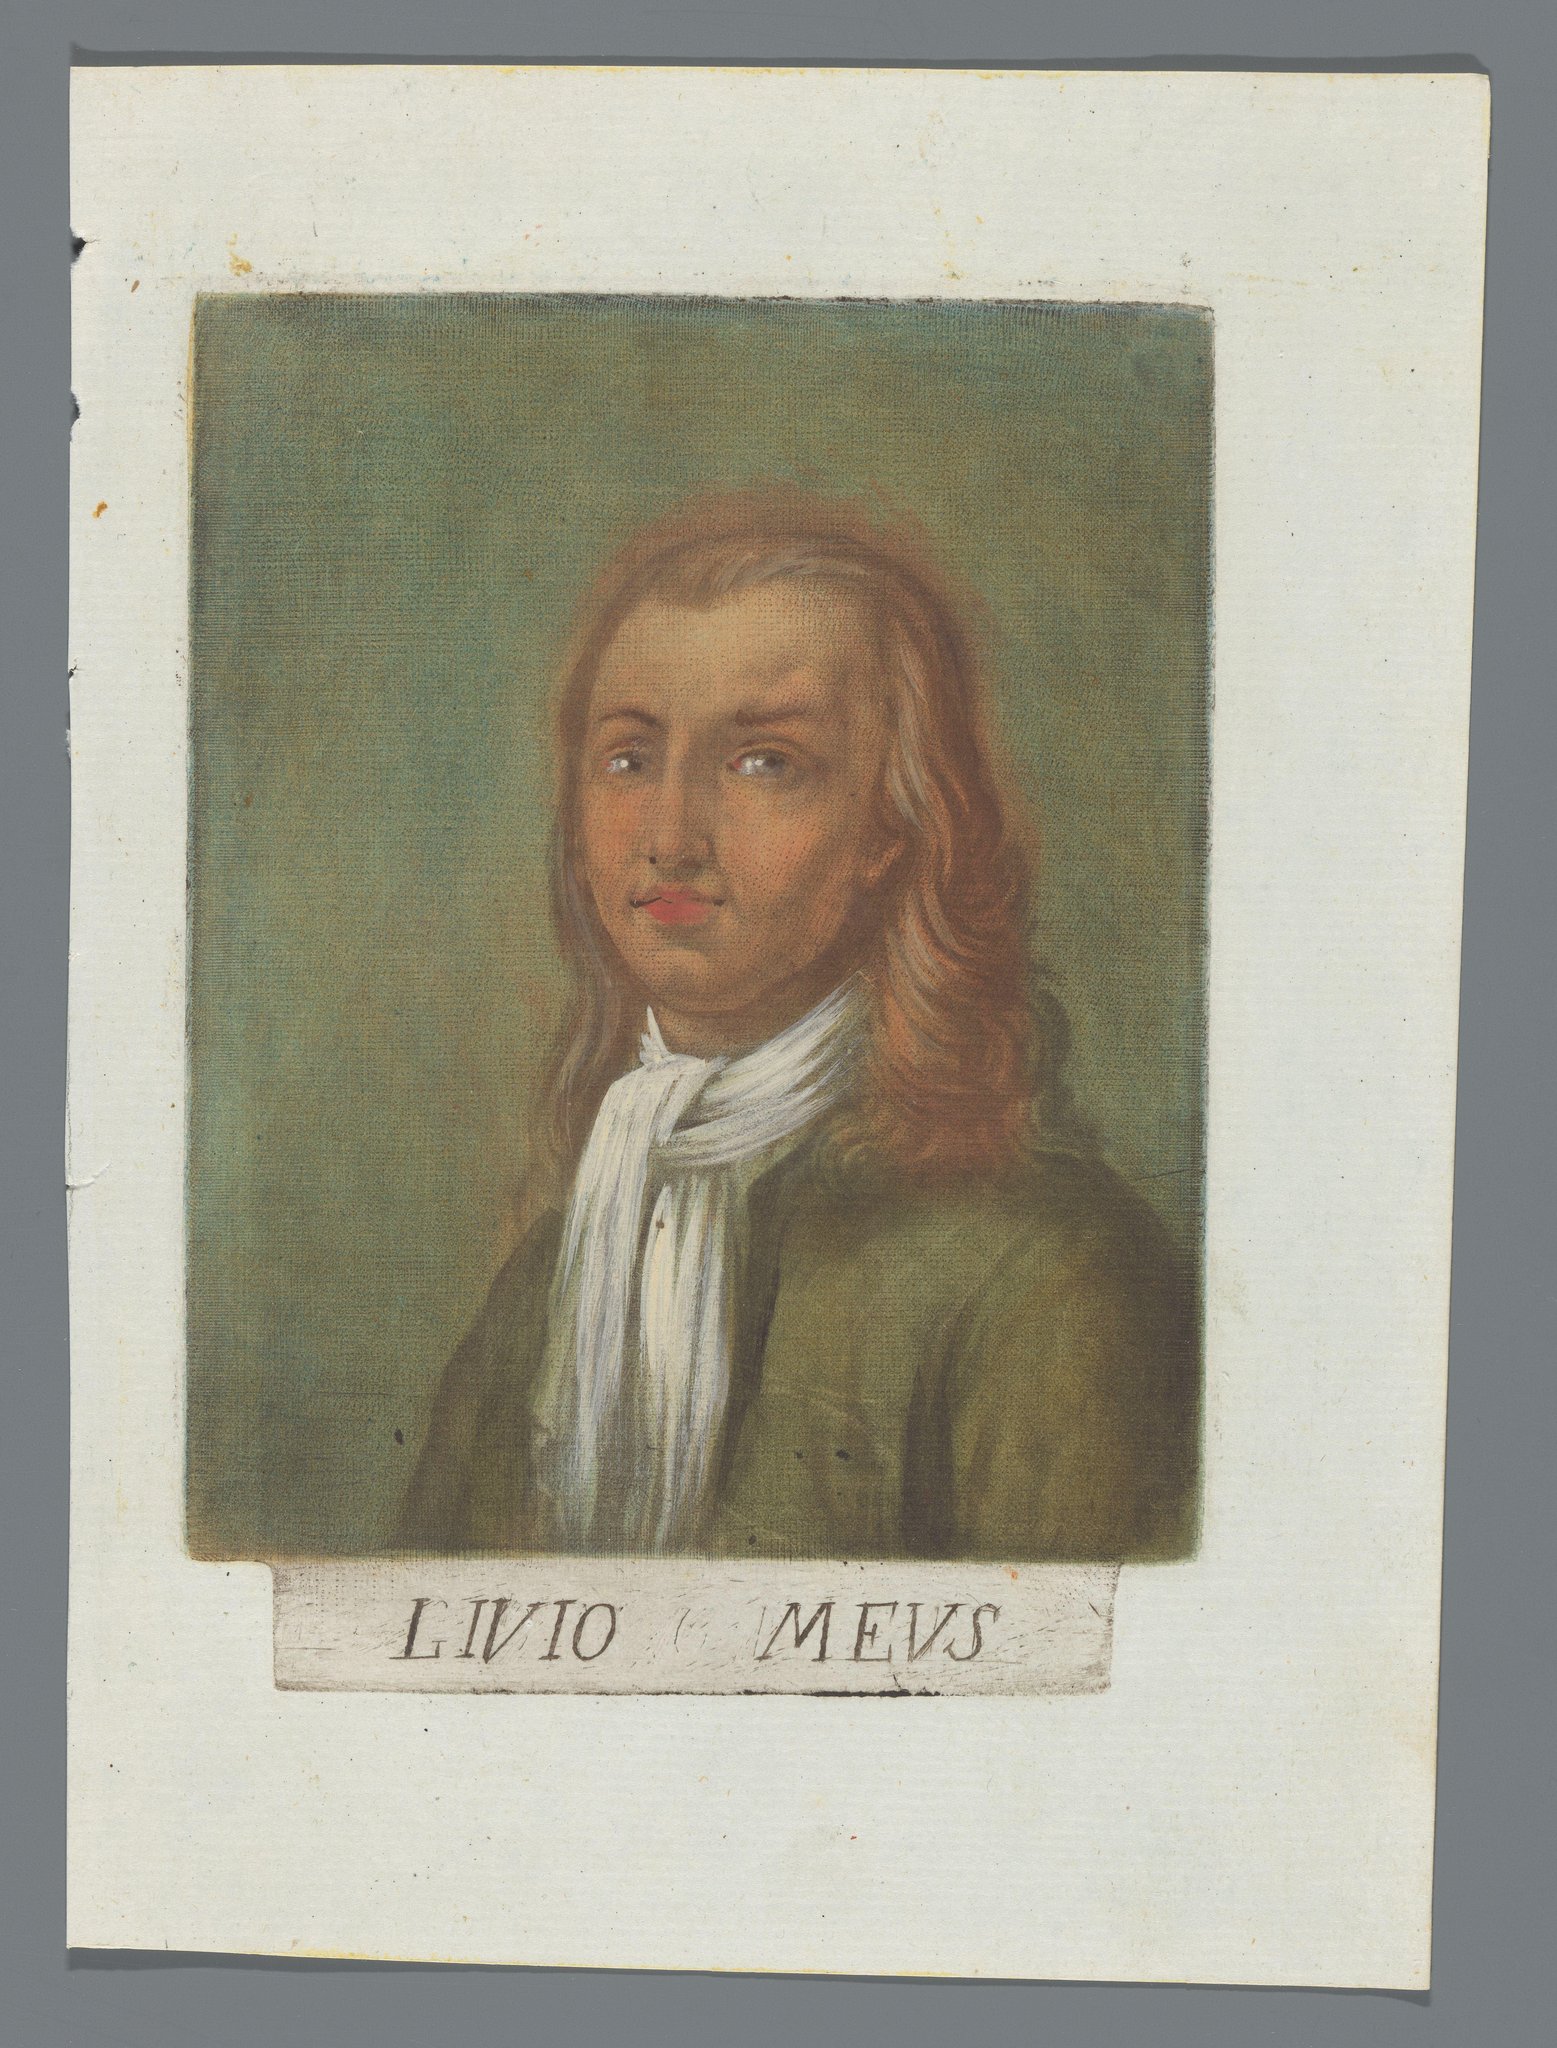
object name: print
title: Livio Mevs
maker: carlo lasinio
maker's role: painter, print maker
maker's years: 1759-1838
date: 1789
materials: gouache, paper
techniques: color mezzotint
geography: florence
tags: draughtsman, lieven mehus, historical persons, portrait, self-portrait of painter, portrait, self-portrait of artist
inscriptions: inscription:, collector's mark: Lugt 2228, number: ‘50’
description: Een prent uit een groep van veertig kleurendrukken met kunstenaarsportretten, gebaseerd op de collectie geschilderde zelfportretten van kunstenaars verzameld door de Medici in Florence. De groep maakt deel uit van het grote werk van Lasinio ‘Gli Autoritratti della Real Galleria di Firenze’, uitgegeven in 1789 met omstreeks 350 kunstenaarsportretten. Van deze uitgave is tot nog toe is geen compleet exemplaar bekend. In de inspringende marges onderaan de prenten zijn de namen van de kunstenaars aangebracht en soms hun levensdata en de plaats van geboorte en sterven en een enkele maal de signatuur van Lasinio en dat van de drukker Labrelis. Getuige de bindgaatjes en lijmresten moeten de prenten ingebonden zijn geweest in een album. De meeste prenten zijn verso voorzien van nummers in potlood, met als laagste nummer 2 en hoogste 93. Tevens zijn er verso Italiaanse opschriften in pen aangebracht met de levensdata van de kunstenaars en de school waartoe zij worden gerekend. Deze opschriften zijn vrijwel alle deels afgesneden. Elf prenten zijn niet genummerd en niet voorzien van opschriften. Deze laatste elf zijn alle gedrukt op blauw papier.